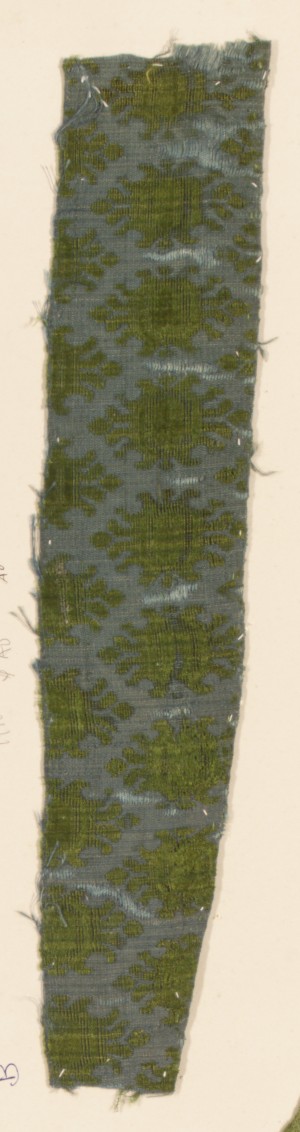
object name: fragment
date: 1501-1600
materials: silk